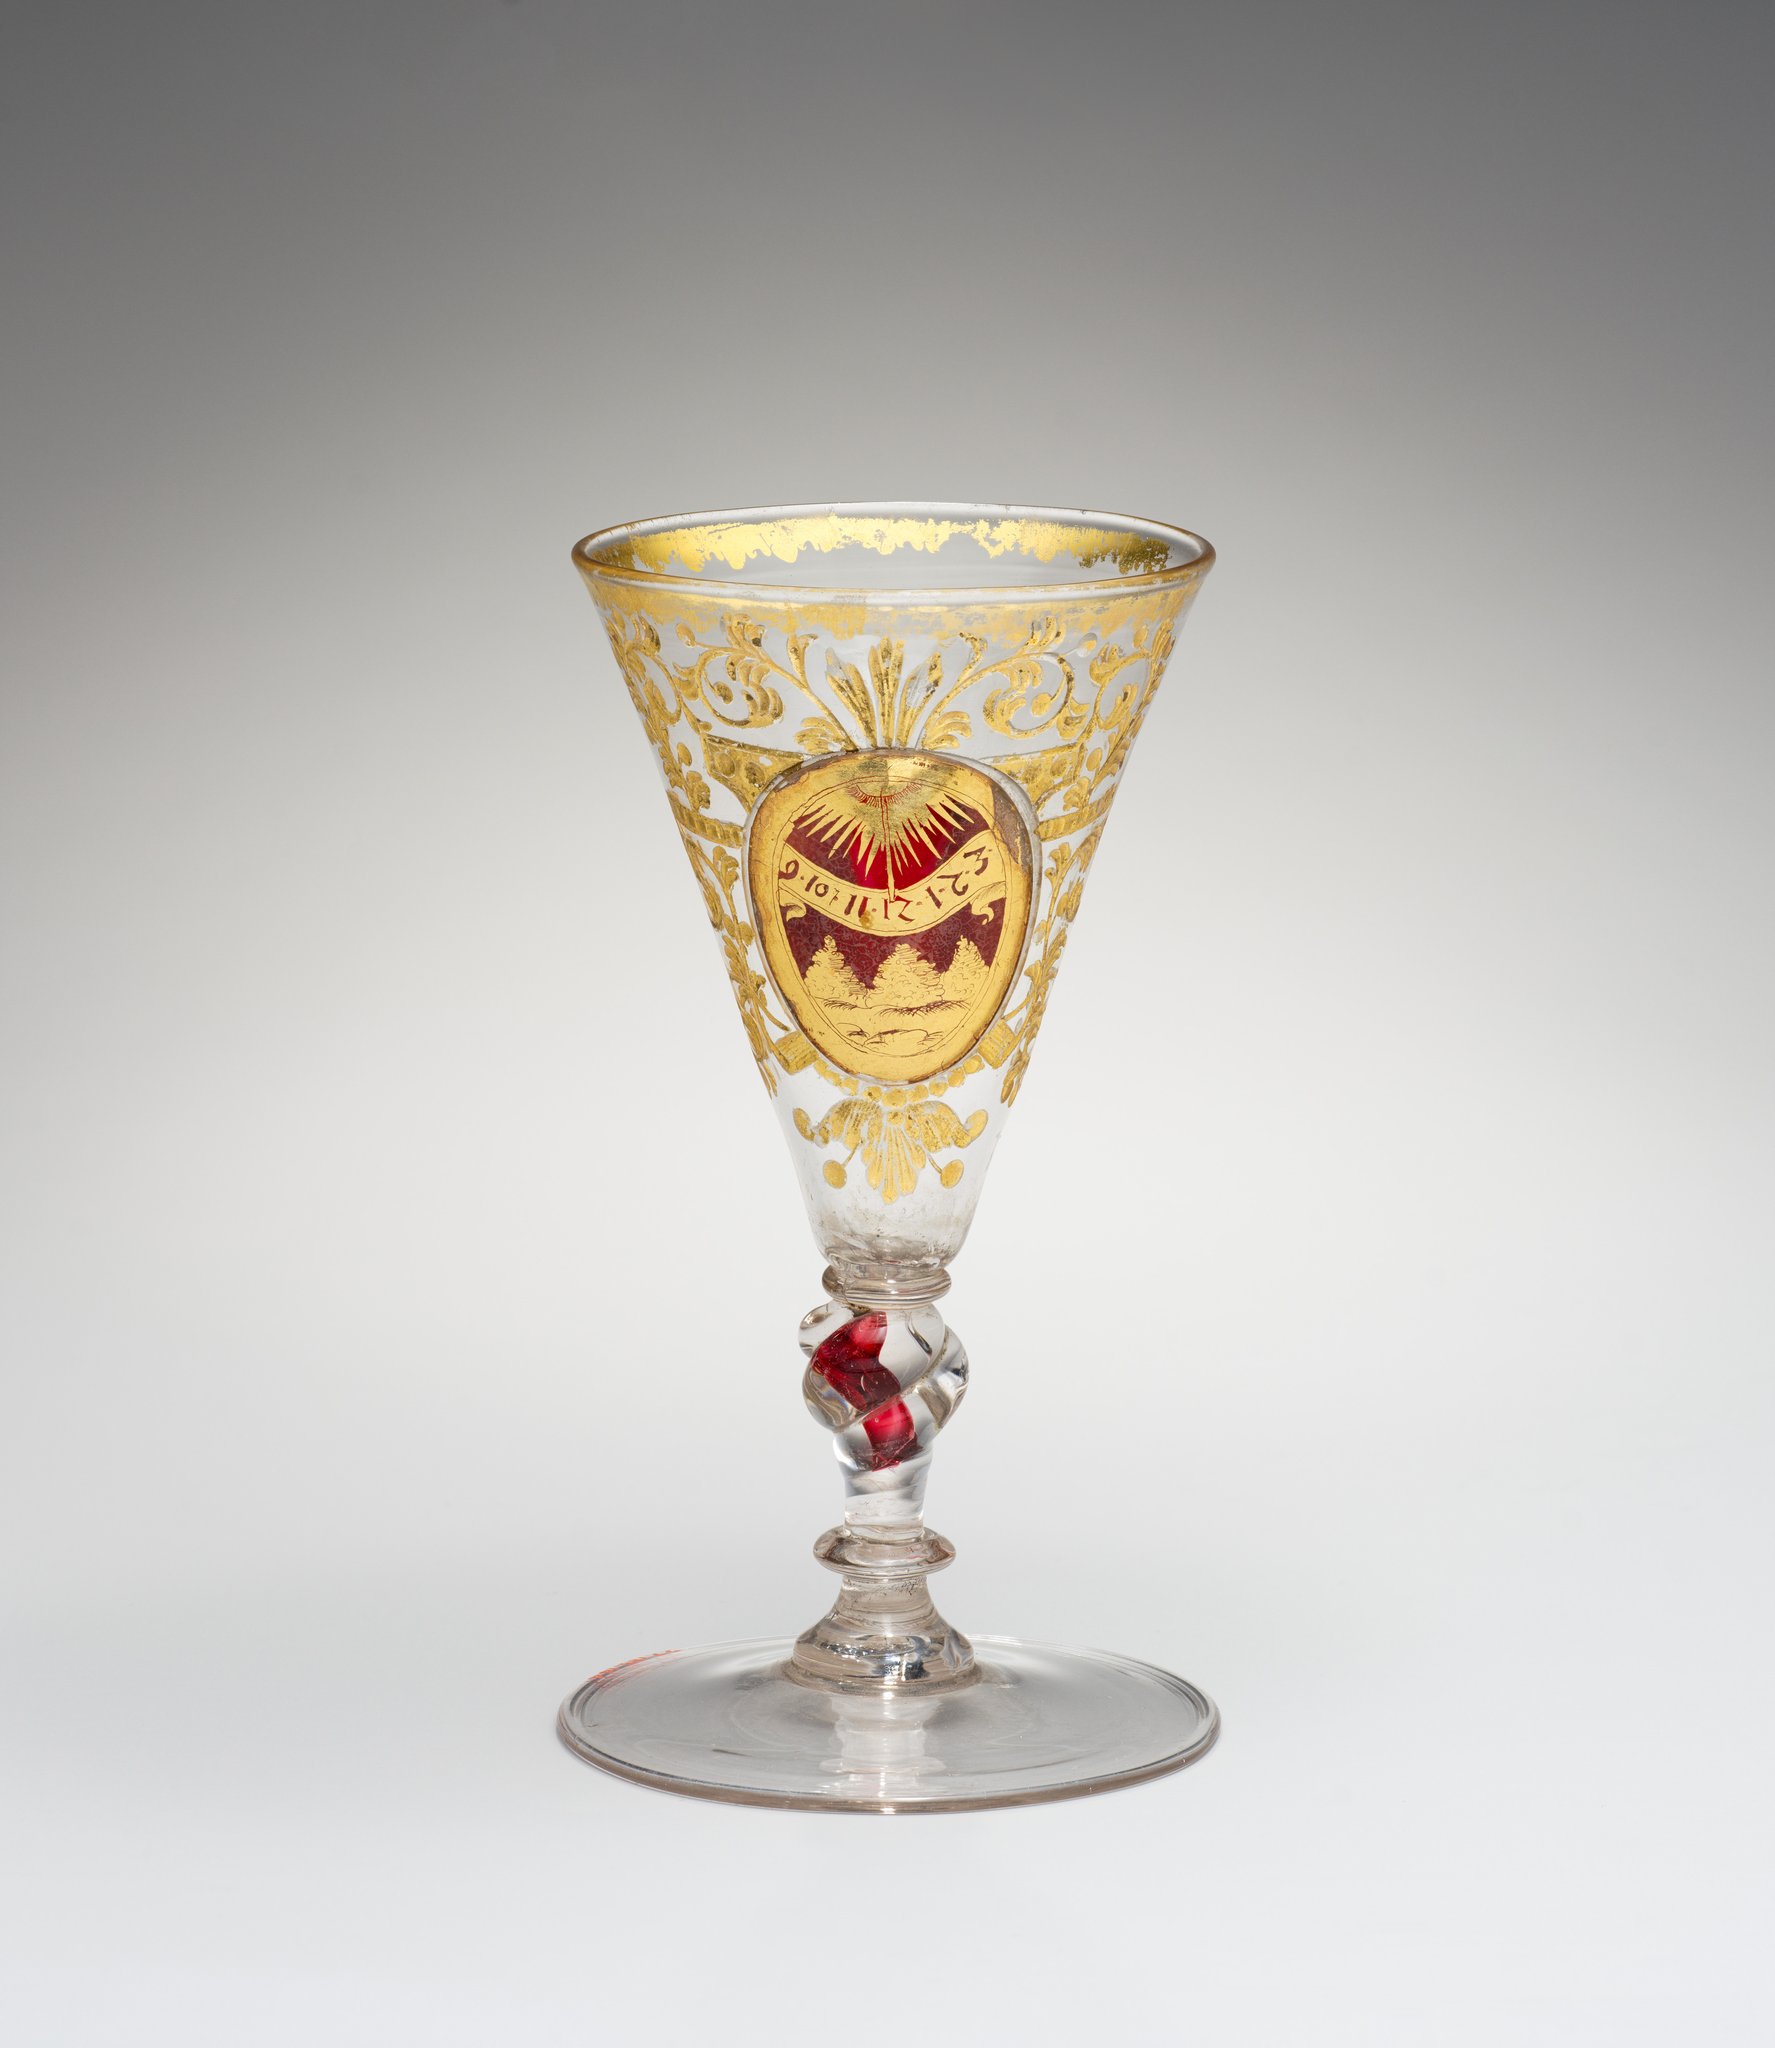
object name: wineglass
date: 1730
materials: glass